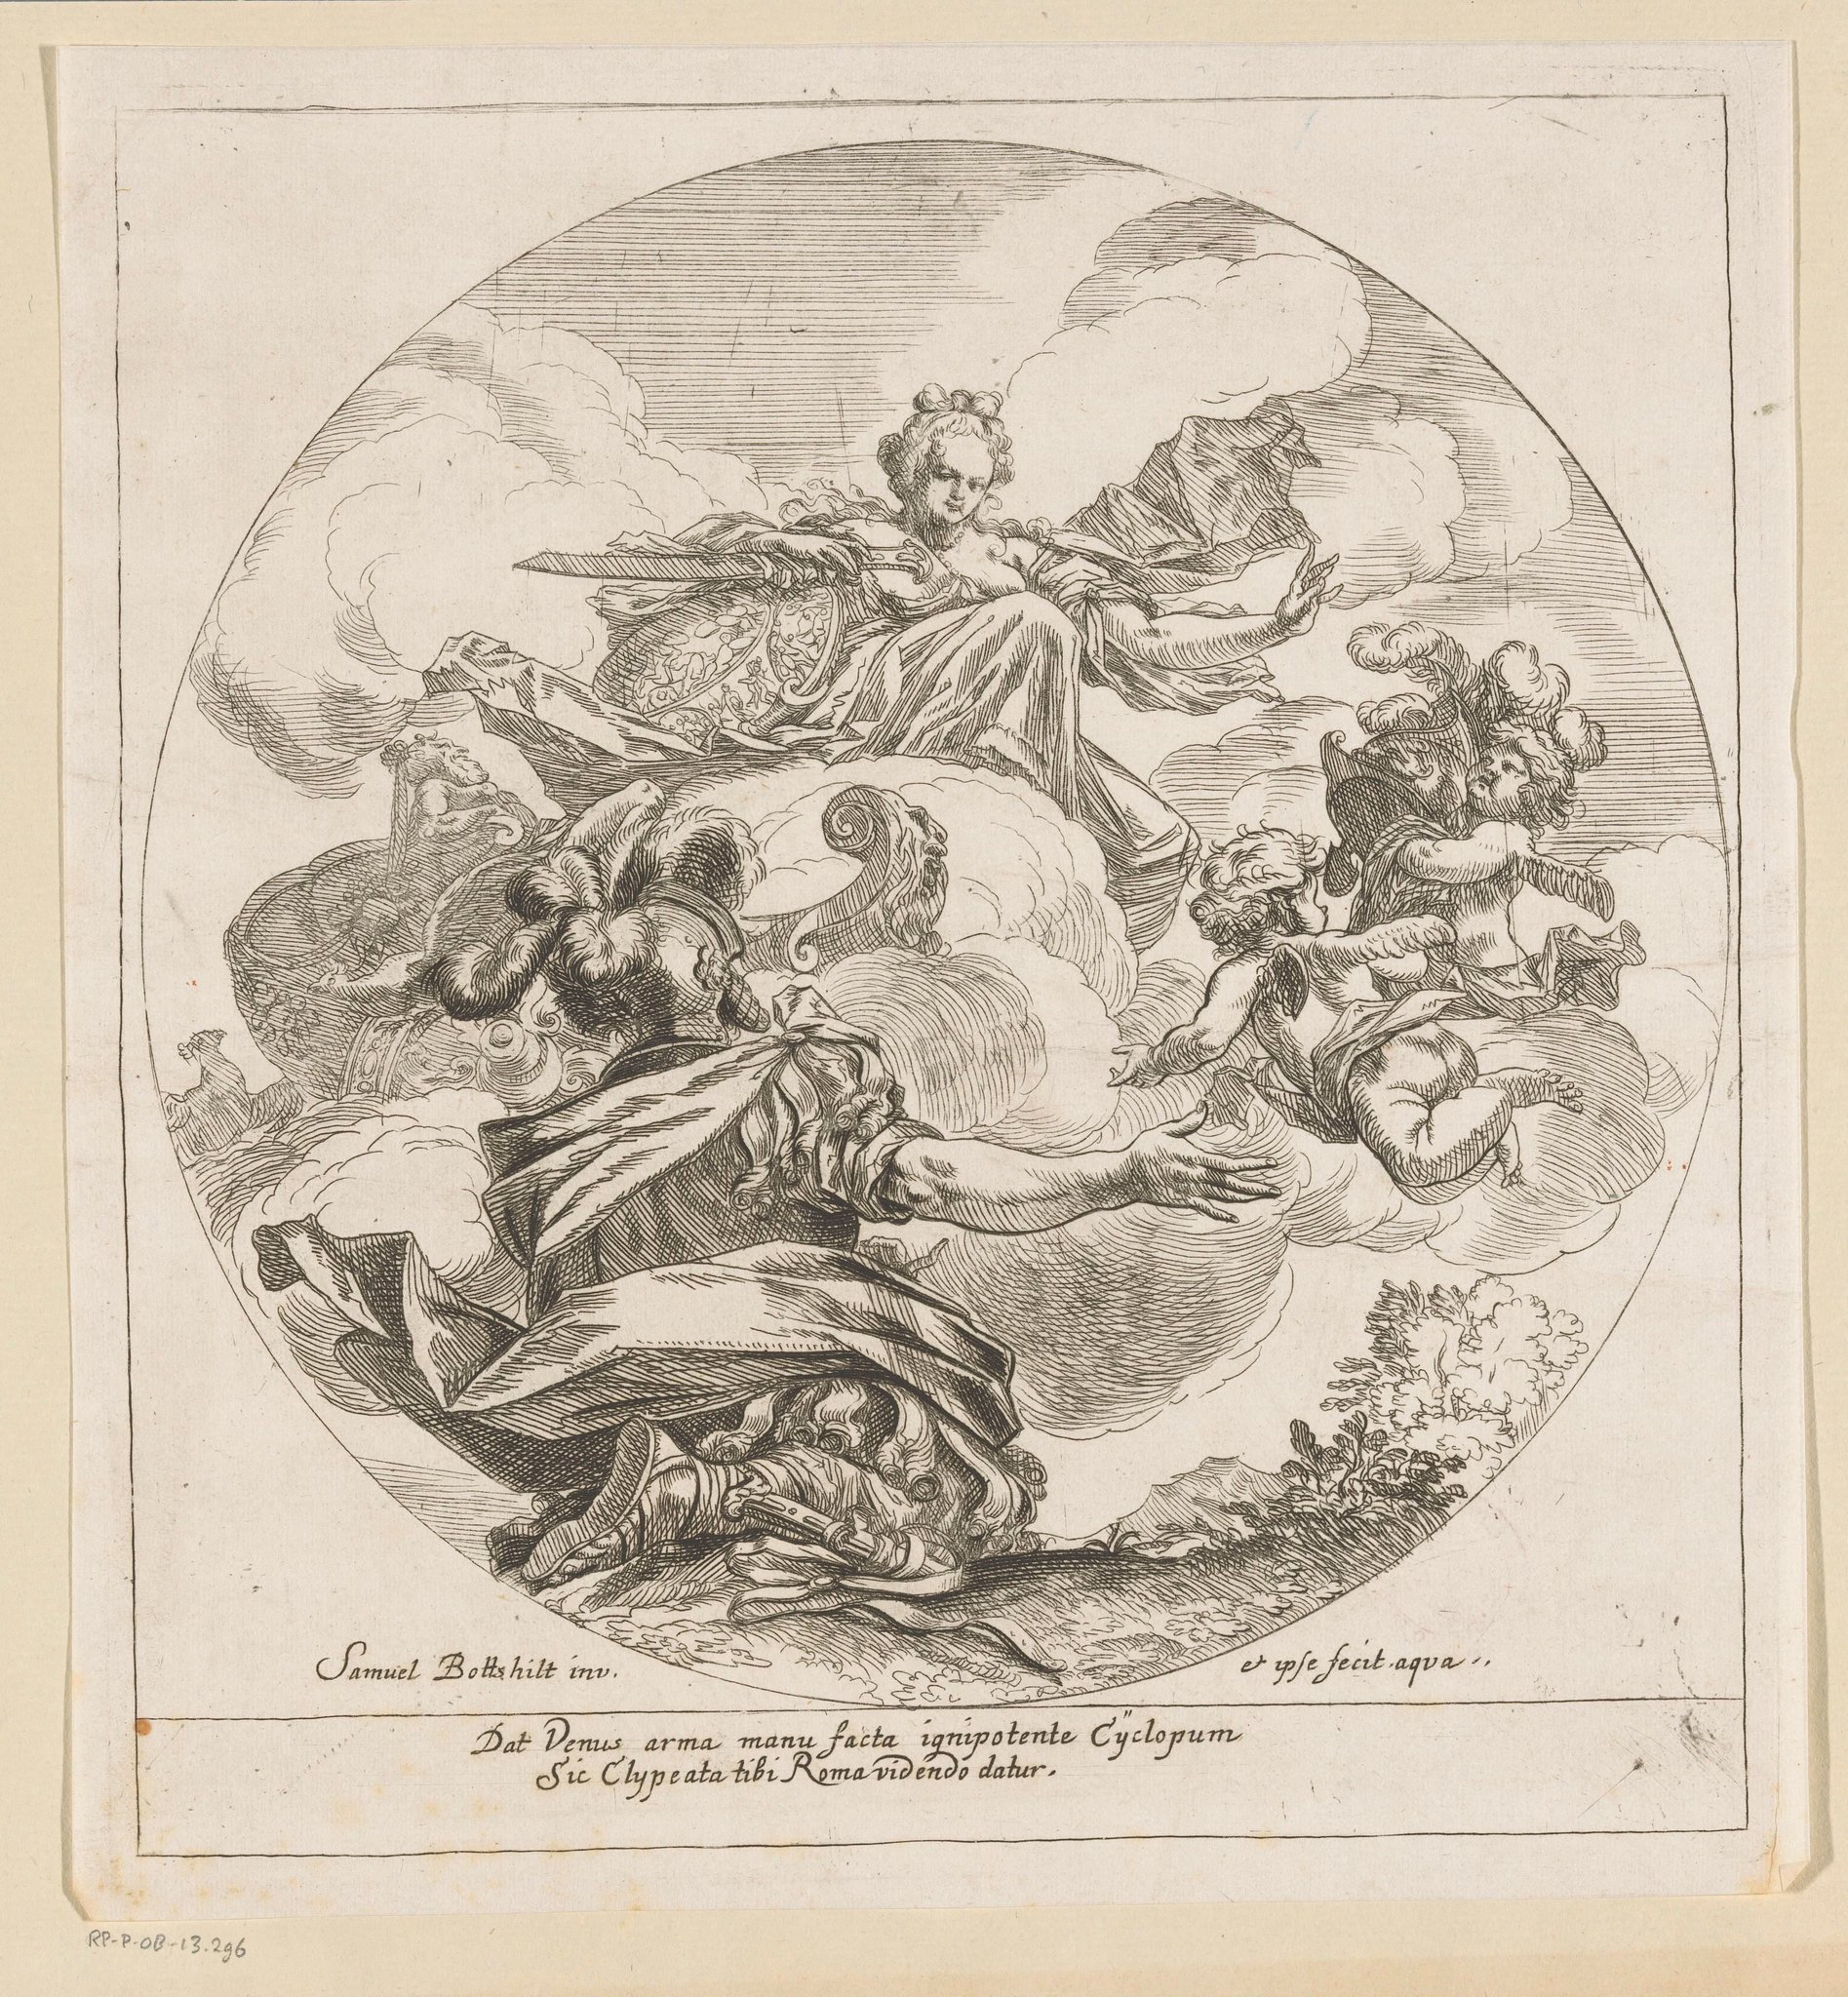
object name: print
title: Diverse ontwerpen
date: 1693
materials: paper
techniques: etching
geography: germany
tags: venus hands over the armour to aeneas, cupids: 'amores', 'amoretti', 'putti'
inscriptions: collector's mark: Lugt 240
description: Prent afkomstig uit de serie 'Opera Varia Historica, Poetica & Iconologica', uitgegeven in 1693. Deze serie omvat vrijwel het complete oeuvre van de kunstenaar en bestaat uit 48 prenten, voornamelijk ontwerpen voor plafonds.